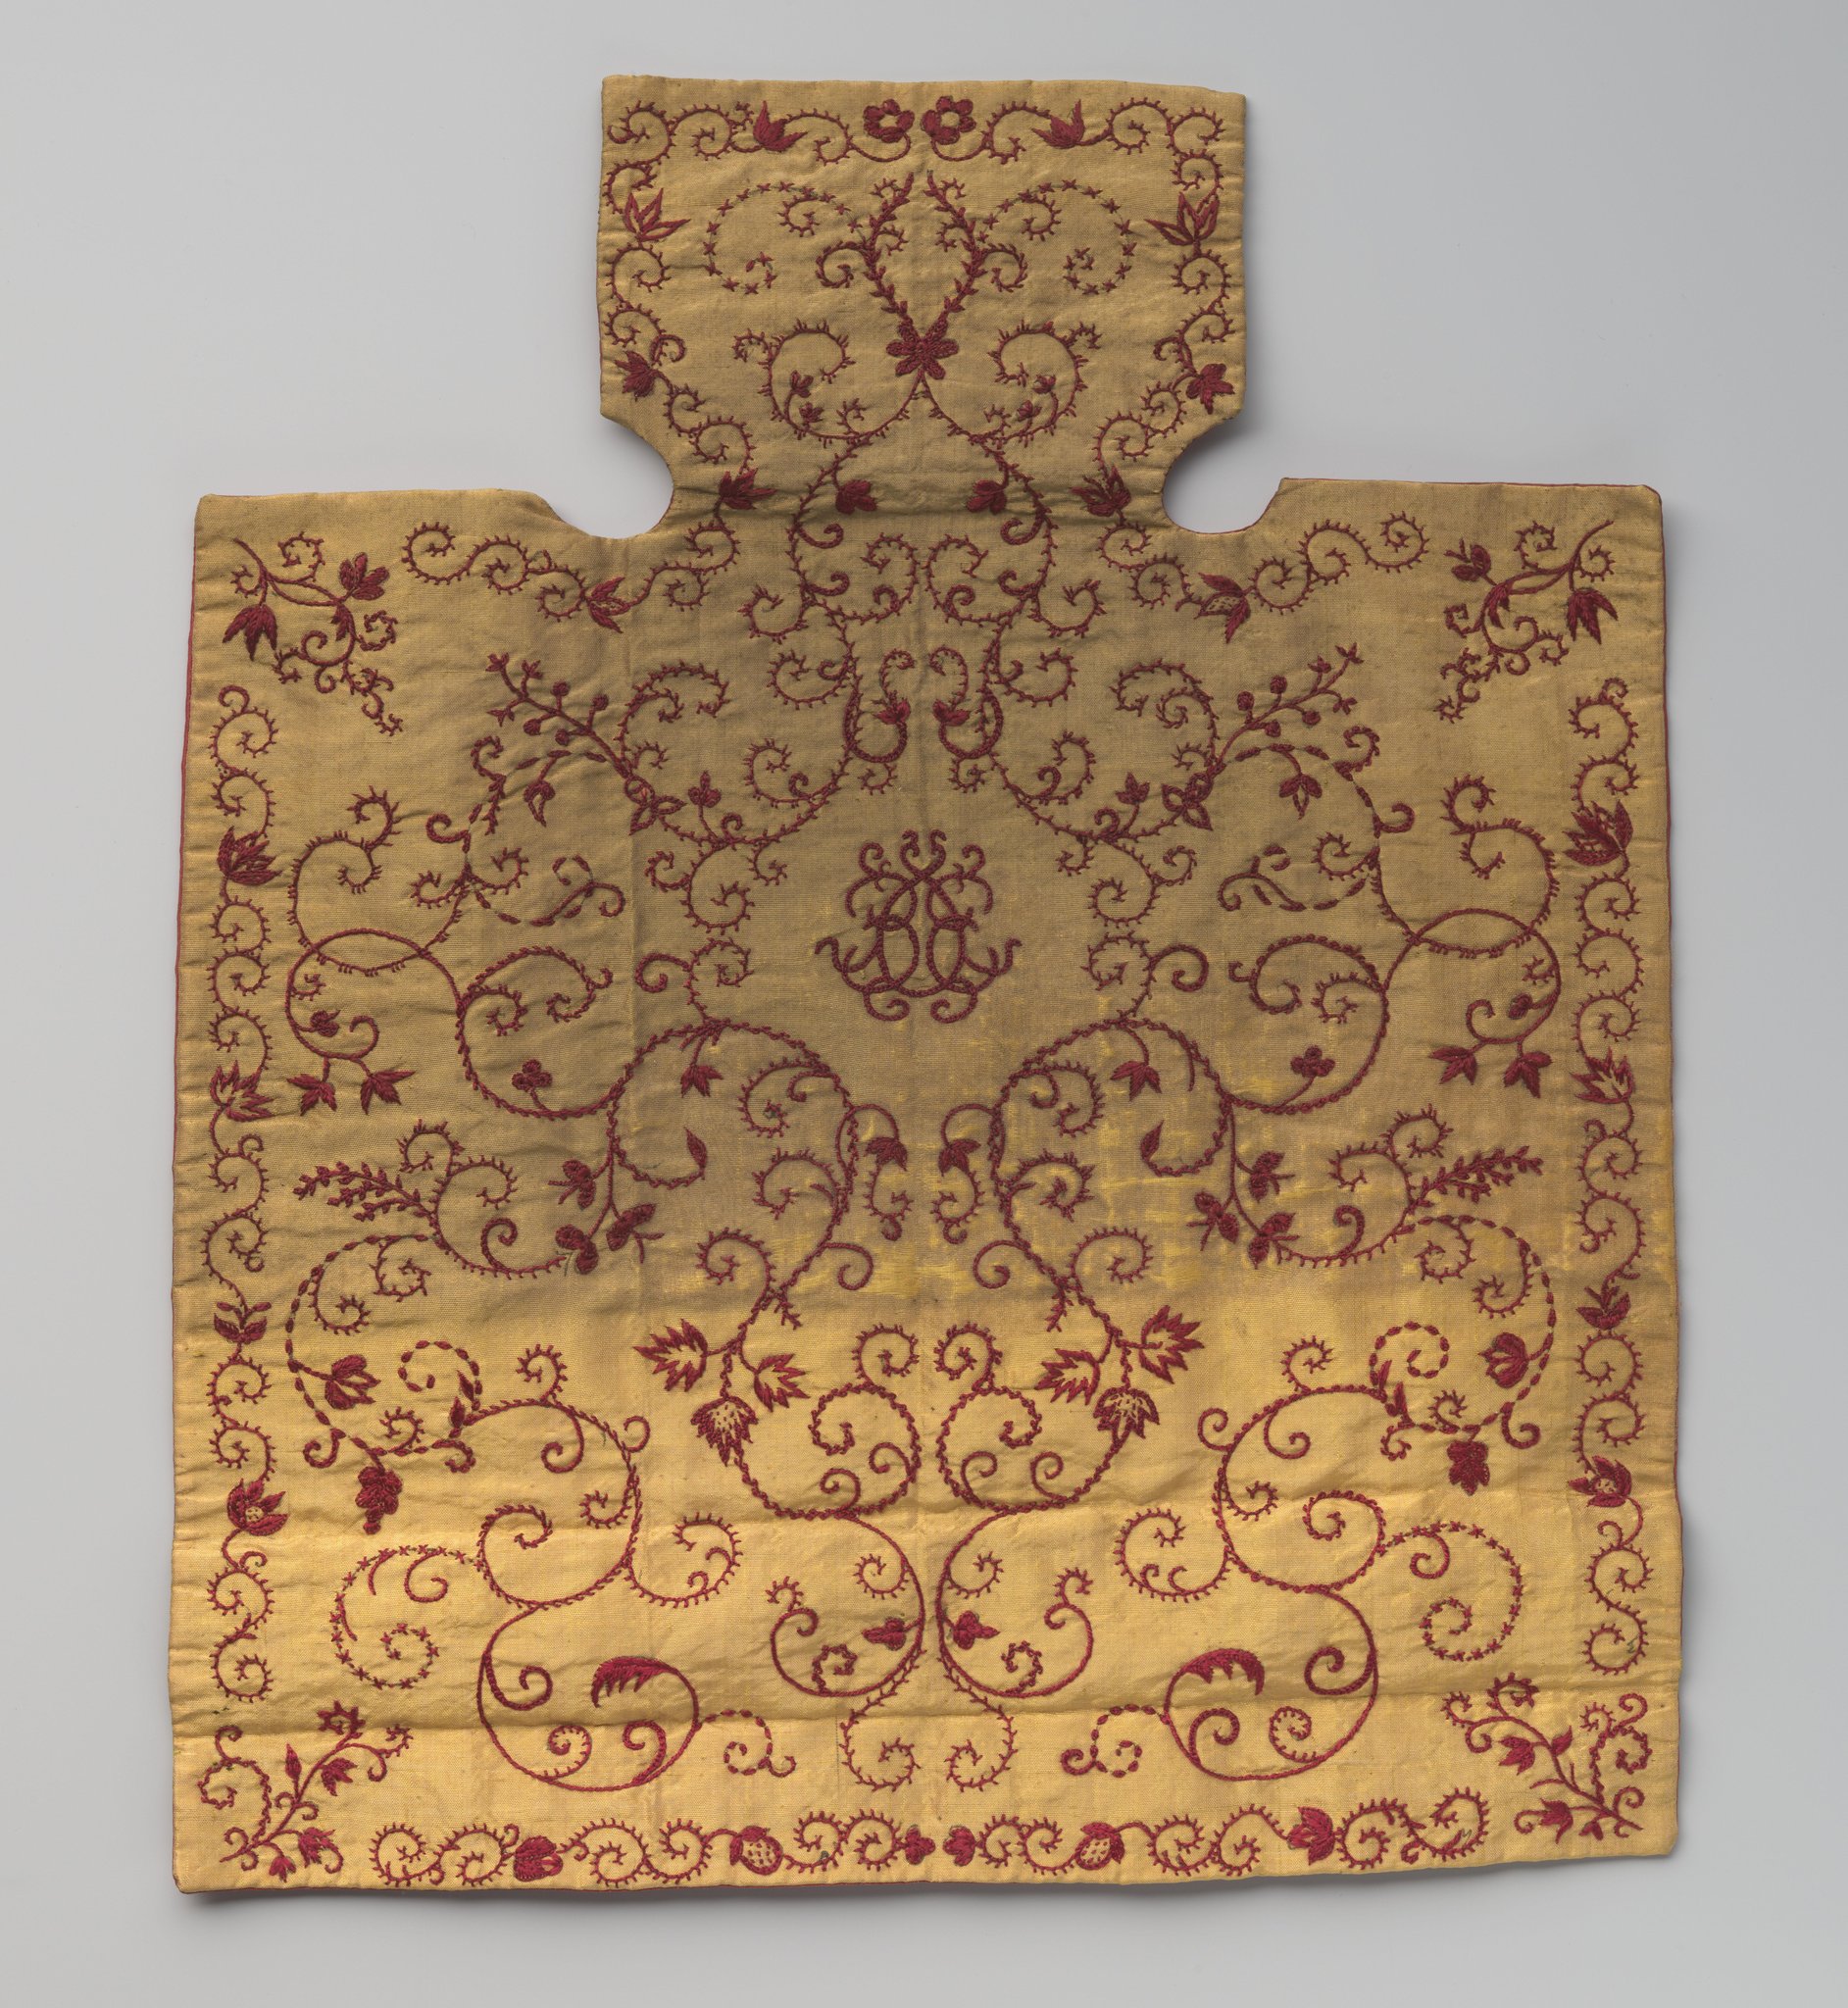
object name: miniature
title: Beddesprei, passend op het kraambed, vervaardigd van gele zijde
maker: Anonymous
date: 1690-1710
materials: cotton, silk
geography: amsterdam